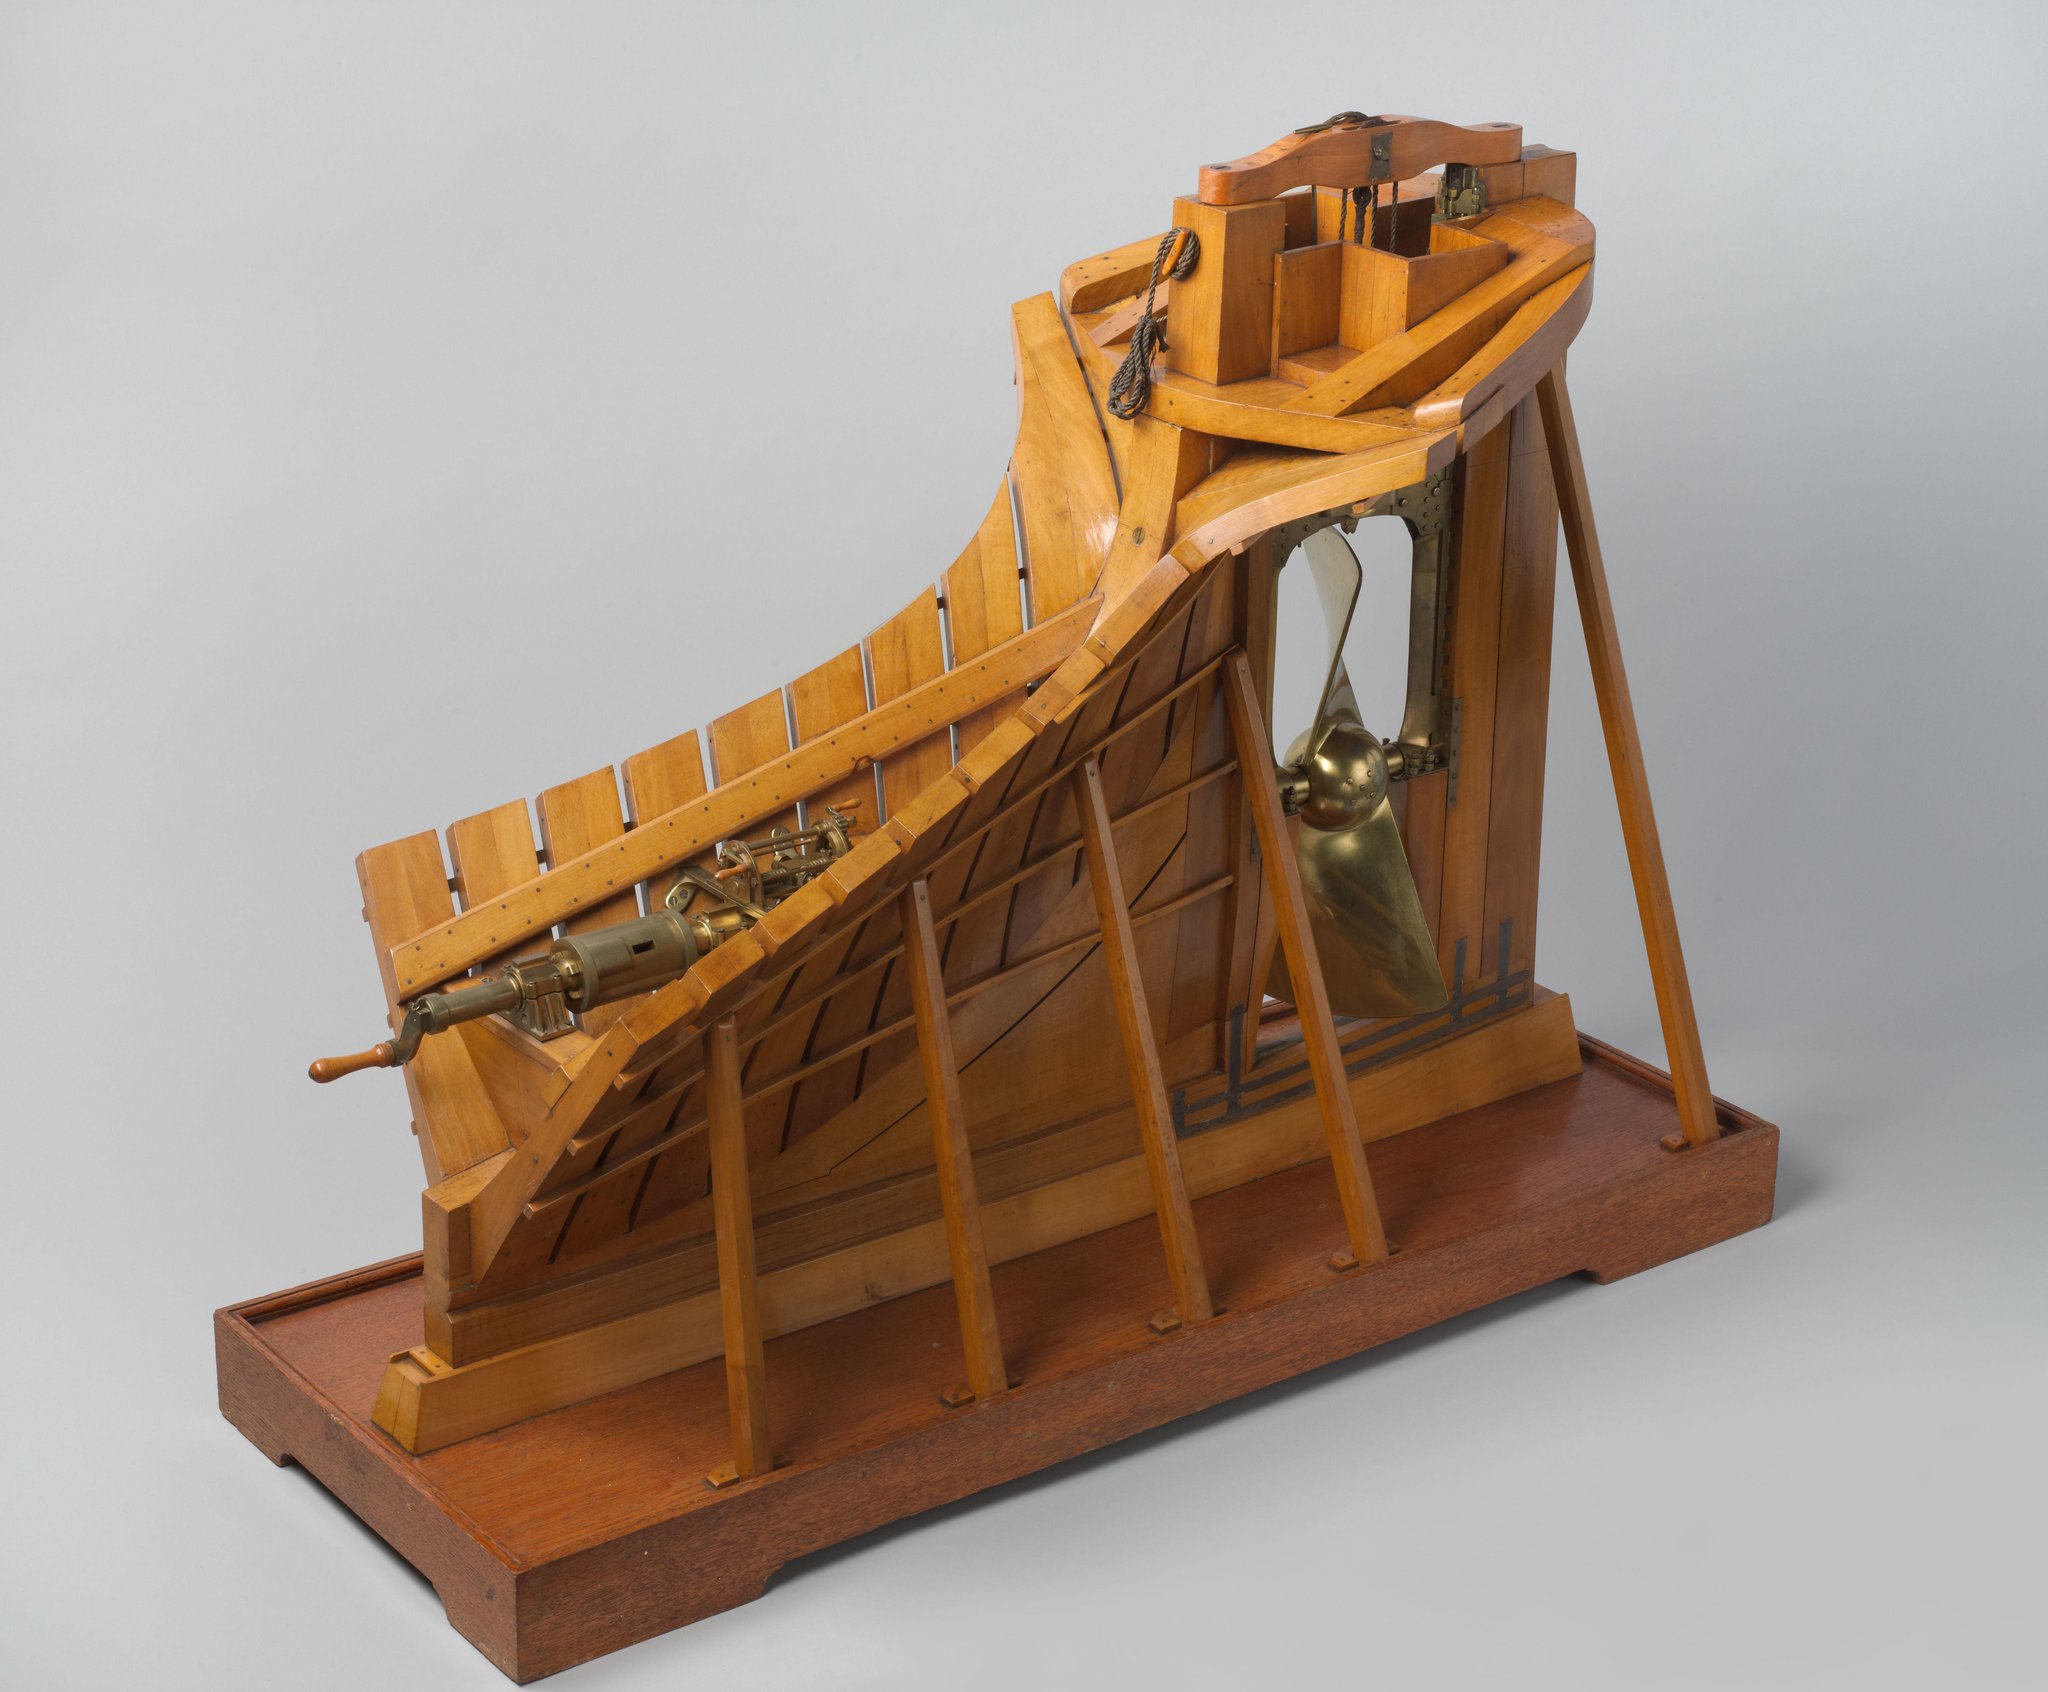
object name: demonstration model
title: Model of a Lifting Screw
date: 1857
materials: brass, fiber, wood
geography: flushing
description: Dit model stelt de schroeflichtinstallatie voor van de Prinses Amalia. Dit schip werd als korvet van 19 stukken Borneo, ontworpen door L.K. Turk, lang 51 m, in 1845 in Rotterdam op stapel gezet. Wegens opheffing van de Marinewerf te Rotterdam uit elkaar genomen en in Vlissingen afgebouwd in 1850-1855 door P.A. Bruin, herdoopt Prinses Amalia en voorzien van hulpstoomvermogen. De machines en schroeflichtinstallatie werden door de Koninklijke Fabriek P. van Vlissingen en Dudok van Heel in Amsterdam gemaakt. Afgevoerd in Nederlands Oost-Indië in 1875.